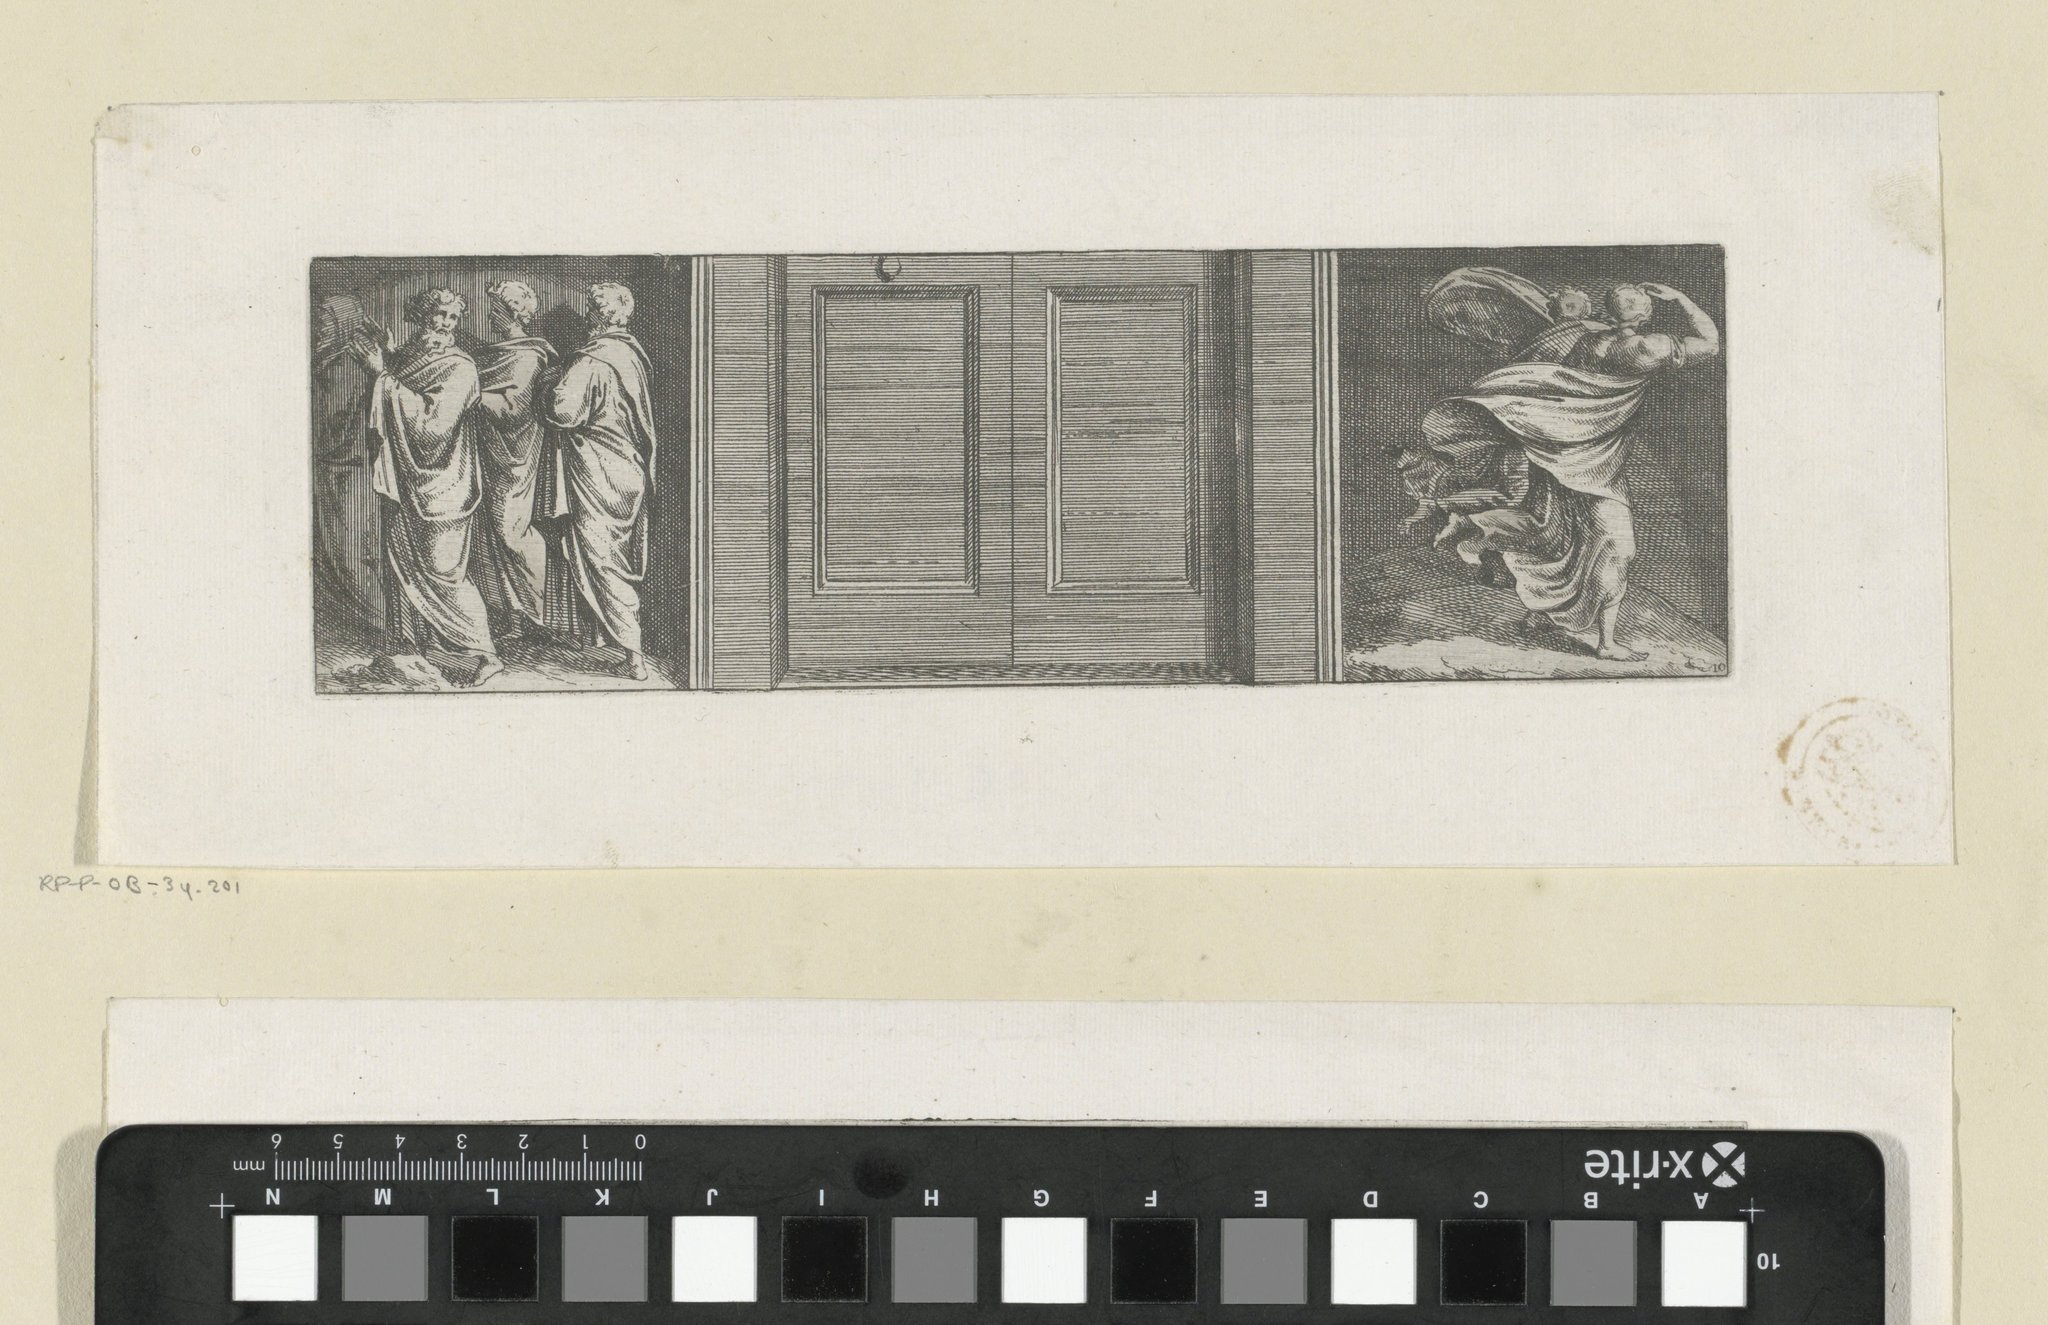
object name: print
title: Verloren gegane schilderderingen in de Vaticaanse Loggia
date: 1645-1700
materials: paper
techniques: engraving, etching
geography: vatican city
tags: christ sends apostles out in pairs (matthew 10:1-16; mark 6:7-11; luke 9:1-5)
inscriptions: collector's mark: Lugt 240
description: Prent naar verloren gegane schilderingen (basamenti) in de Vaticaanse Loggia naar ontwerp van Rafaël, mogelijk door Perino del Vaga geschilderd.